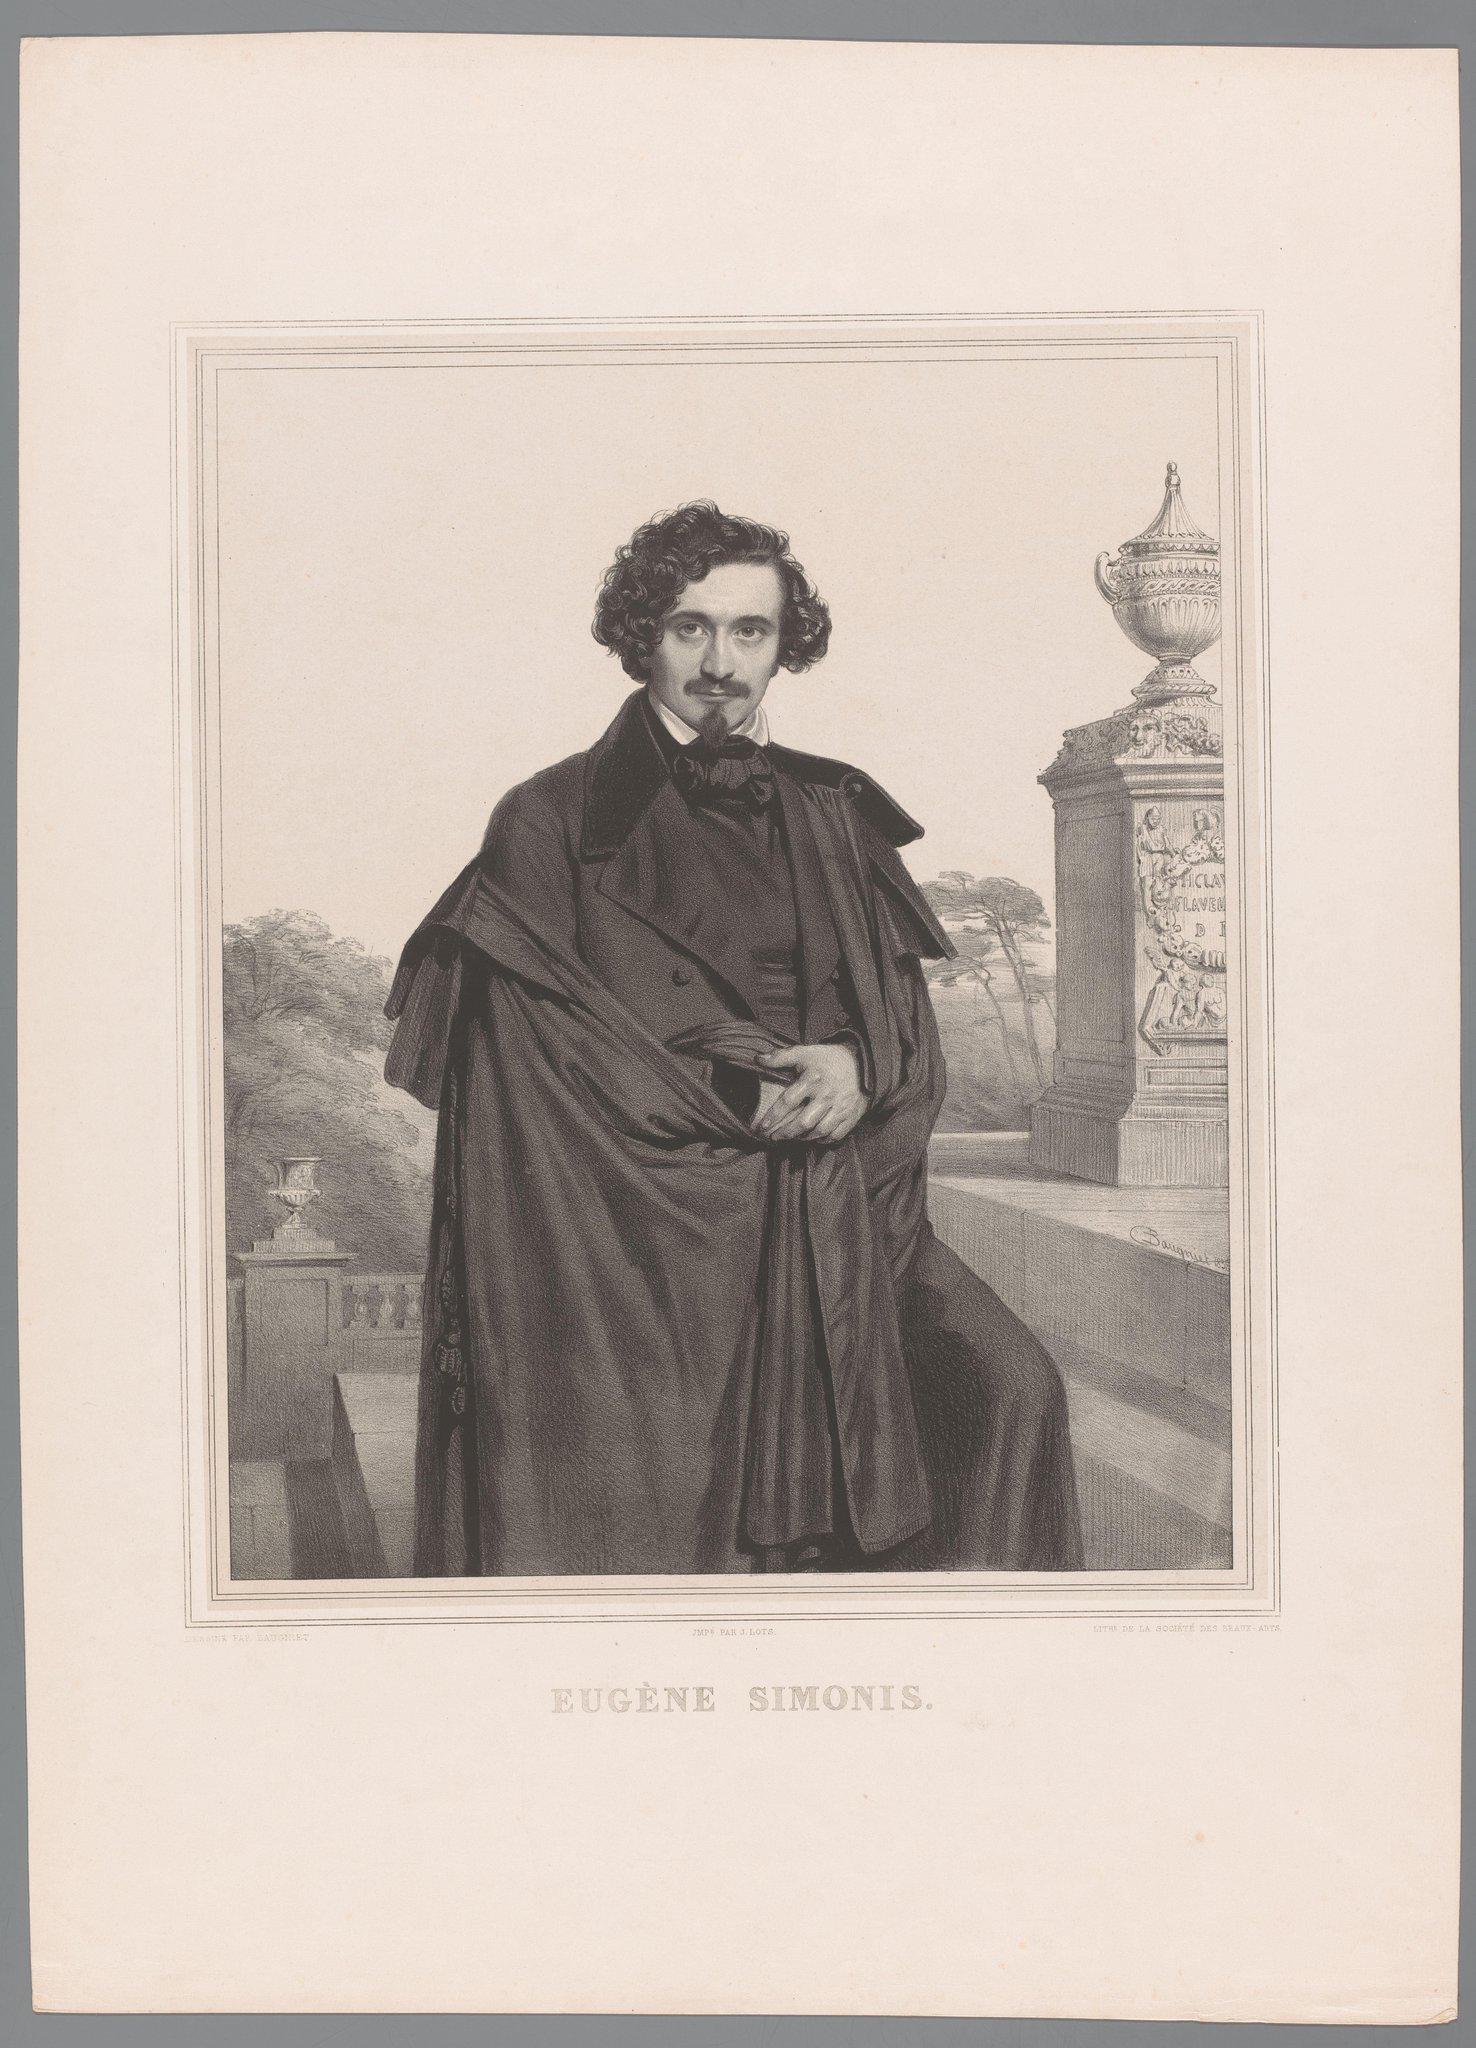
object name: print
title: Eugène Simonis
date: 1838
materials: paper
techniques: lithograph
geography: brussels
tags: brussels, louis eugène simonis, portrait, self-portrait of sculptor, adult man, historical persons, garden ornaments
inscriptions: date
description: Andere staat verschenen in: Baugniet, Charles. Les artistes contemporains: portraits lithographiés d'après nature, accompagnés de notices sur la vie et les ouvrages de chacun d'eux. Brussel: De Wasme-Pletinckx, [1836-1840].